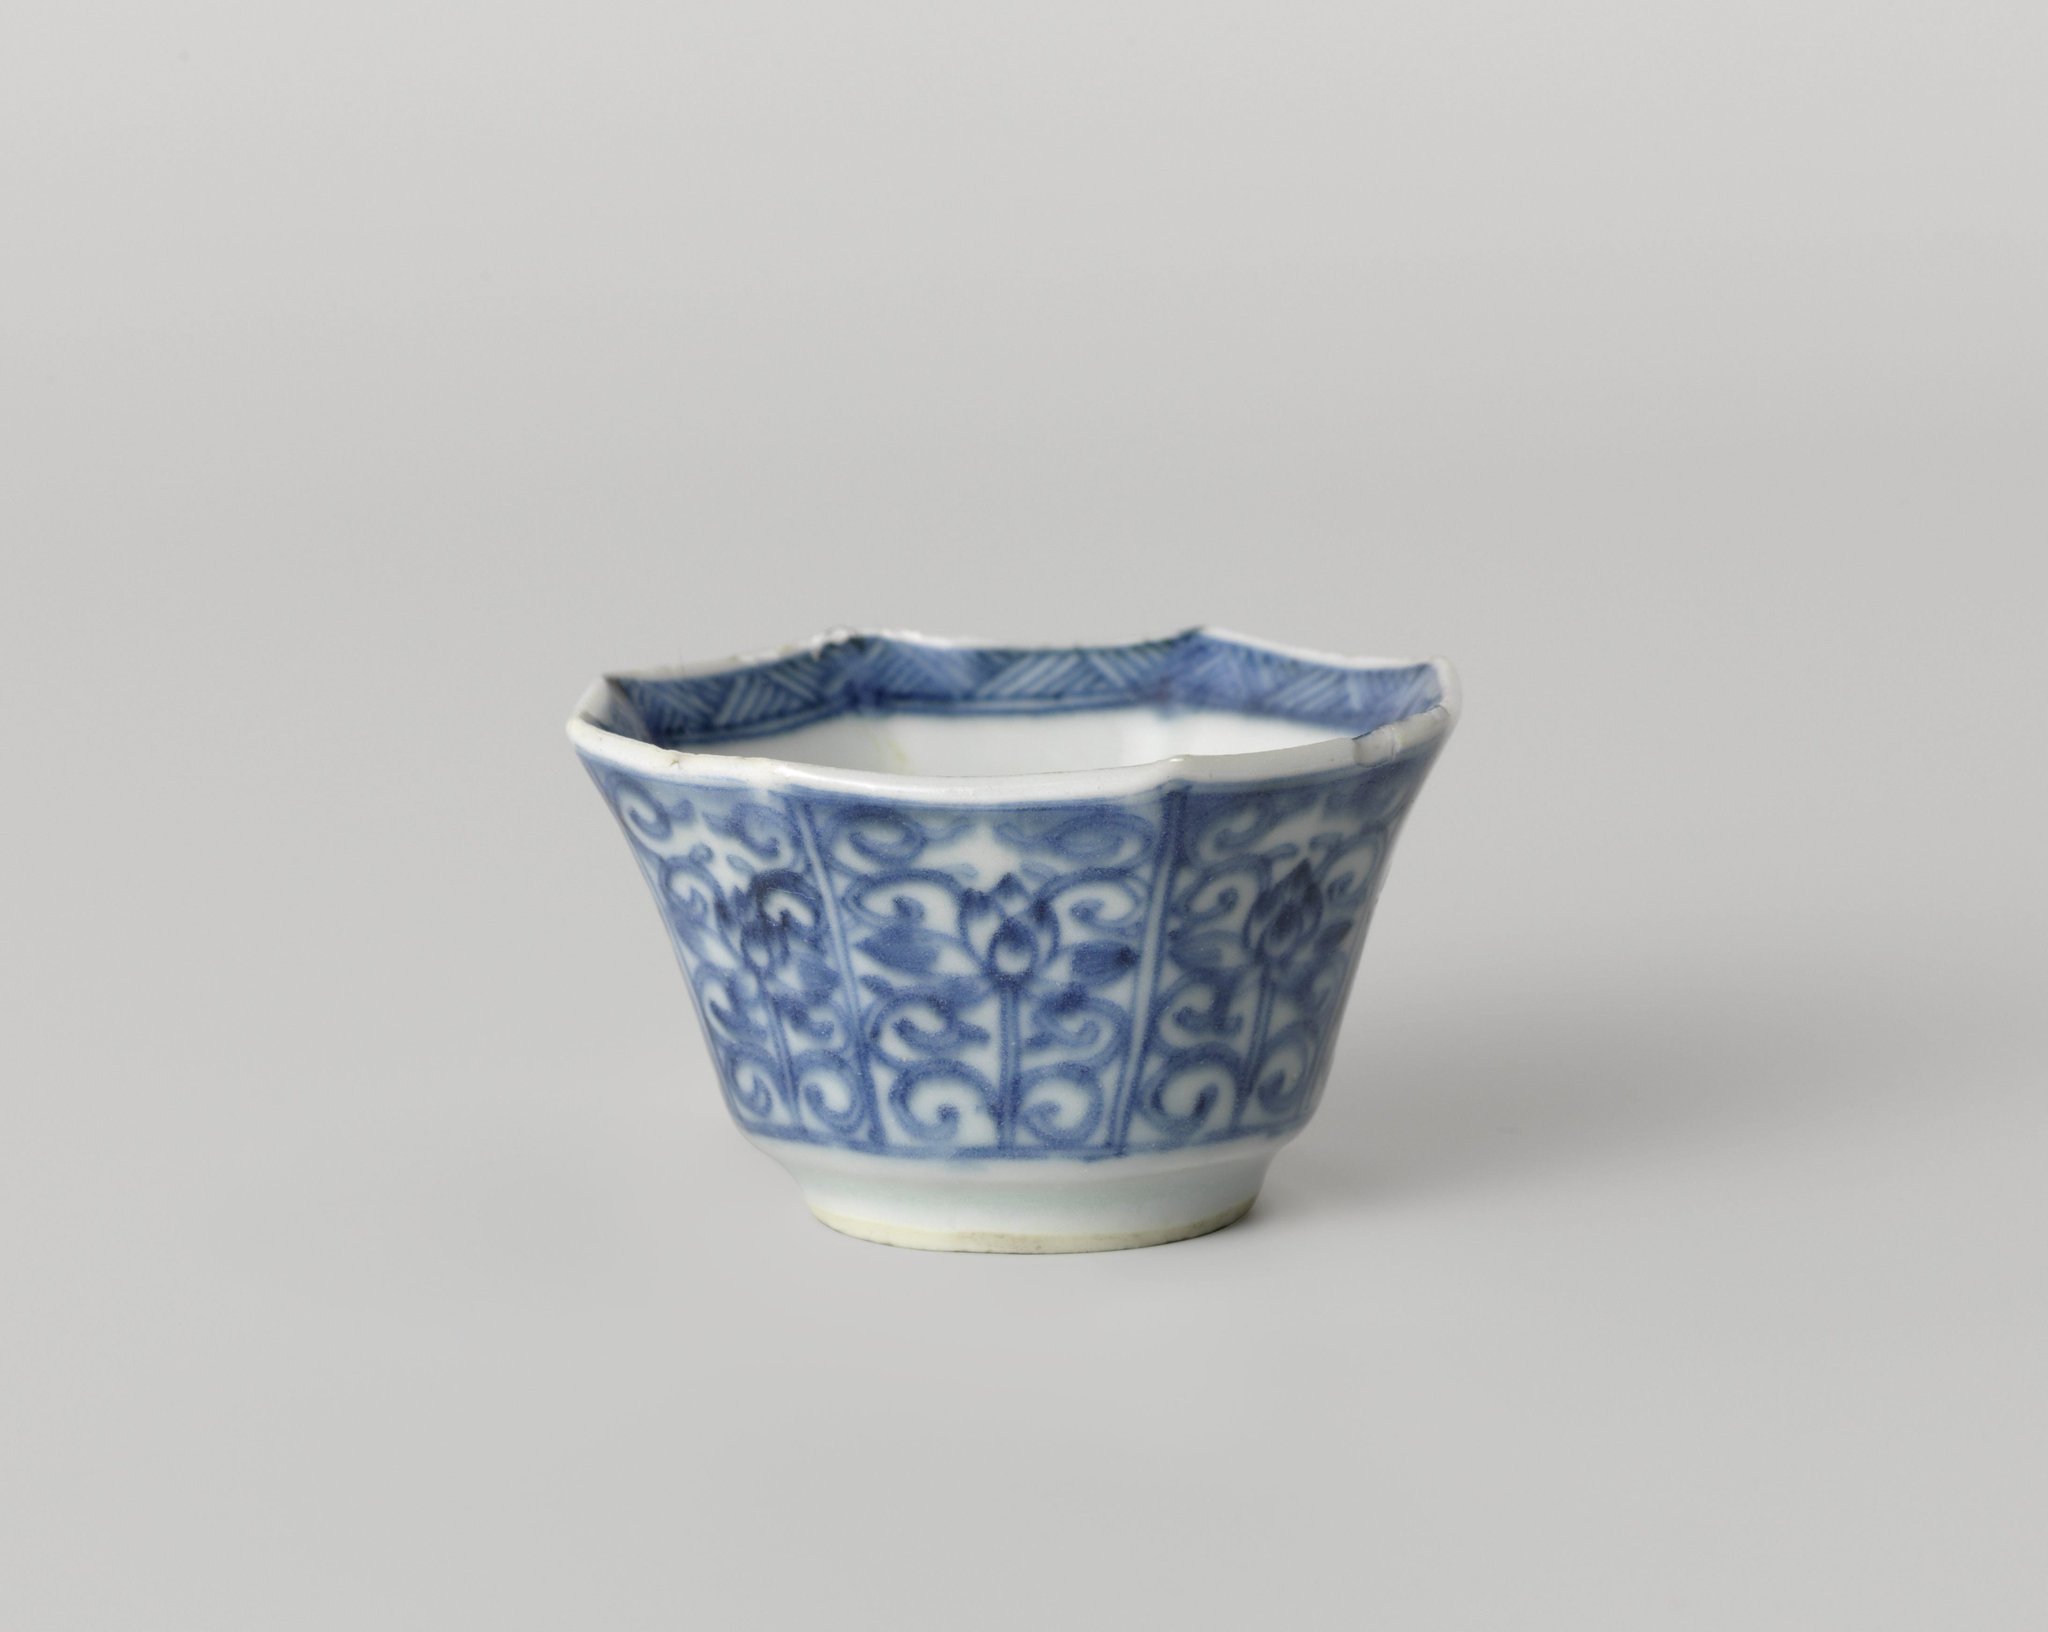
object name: cup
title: Octagonal cup with flower scrolls in panel decoration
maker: Anonymous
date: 1700-1724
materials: cobalt, glaze, paint, porcelain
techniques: firing, forming, turning, vitrification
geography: china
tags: ornament derived from plant forms, flowers ~ ornament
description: Kop van porselein, achtkantig, zonder oor. Beschilderd in onderglazuurblauw met een symmetrisch decor van een bloem en voluuttakken, dat zich op elk vak herhaalt. Langs de binnenzijde van de mondrand een geometrische lijst van schuine lijnen. Op de bodem een achthoek, waarin een bloem.